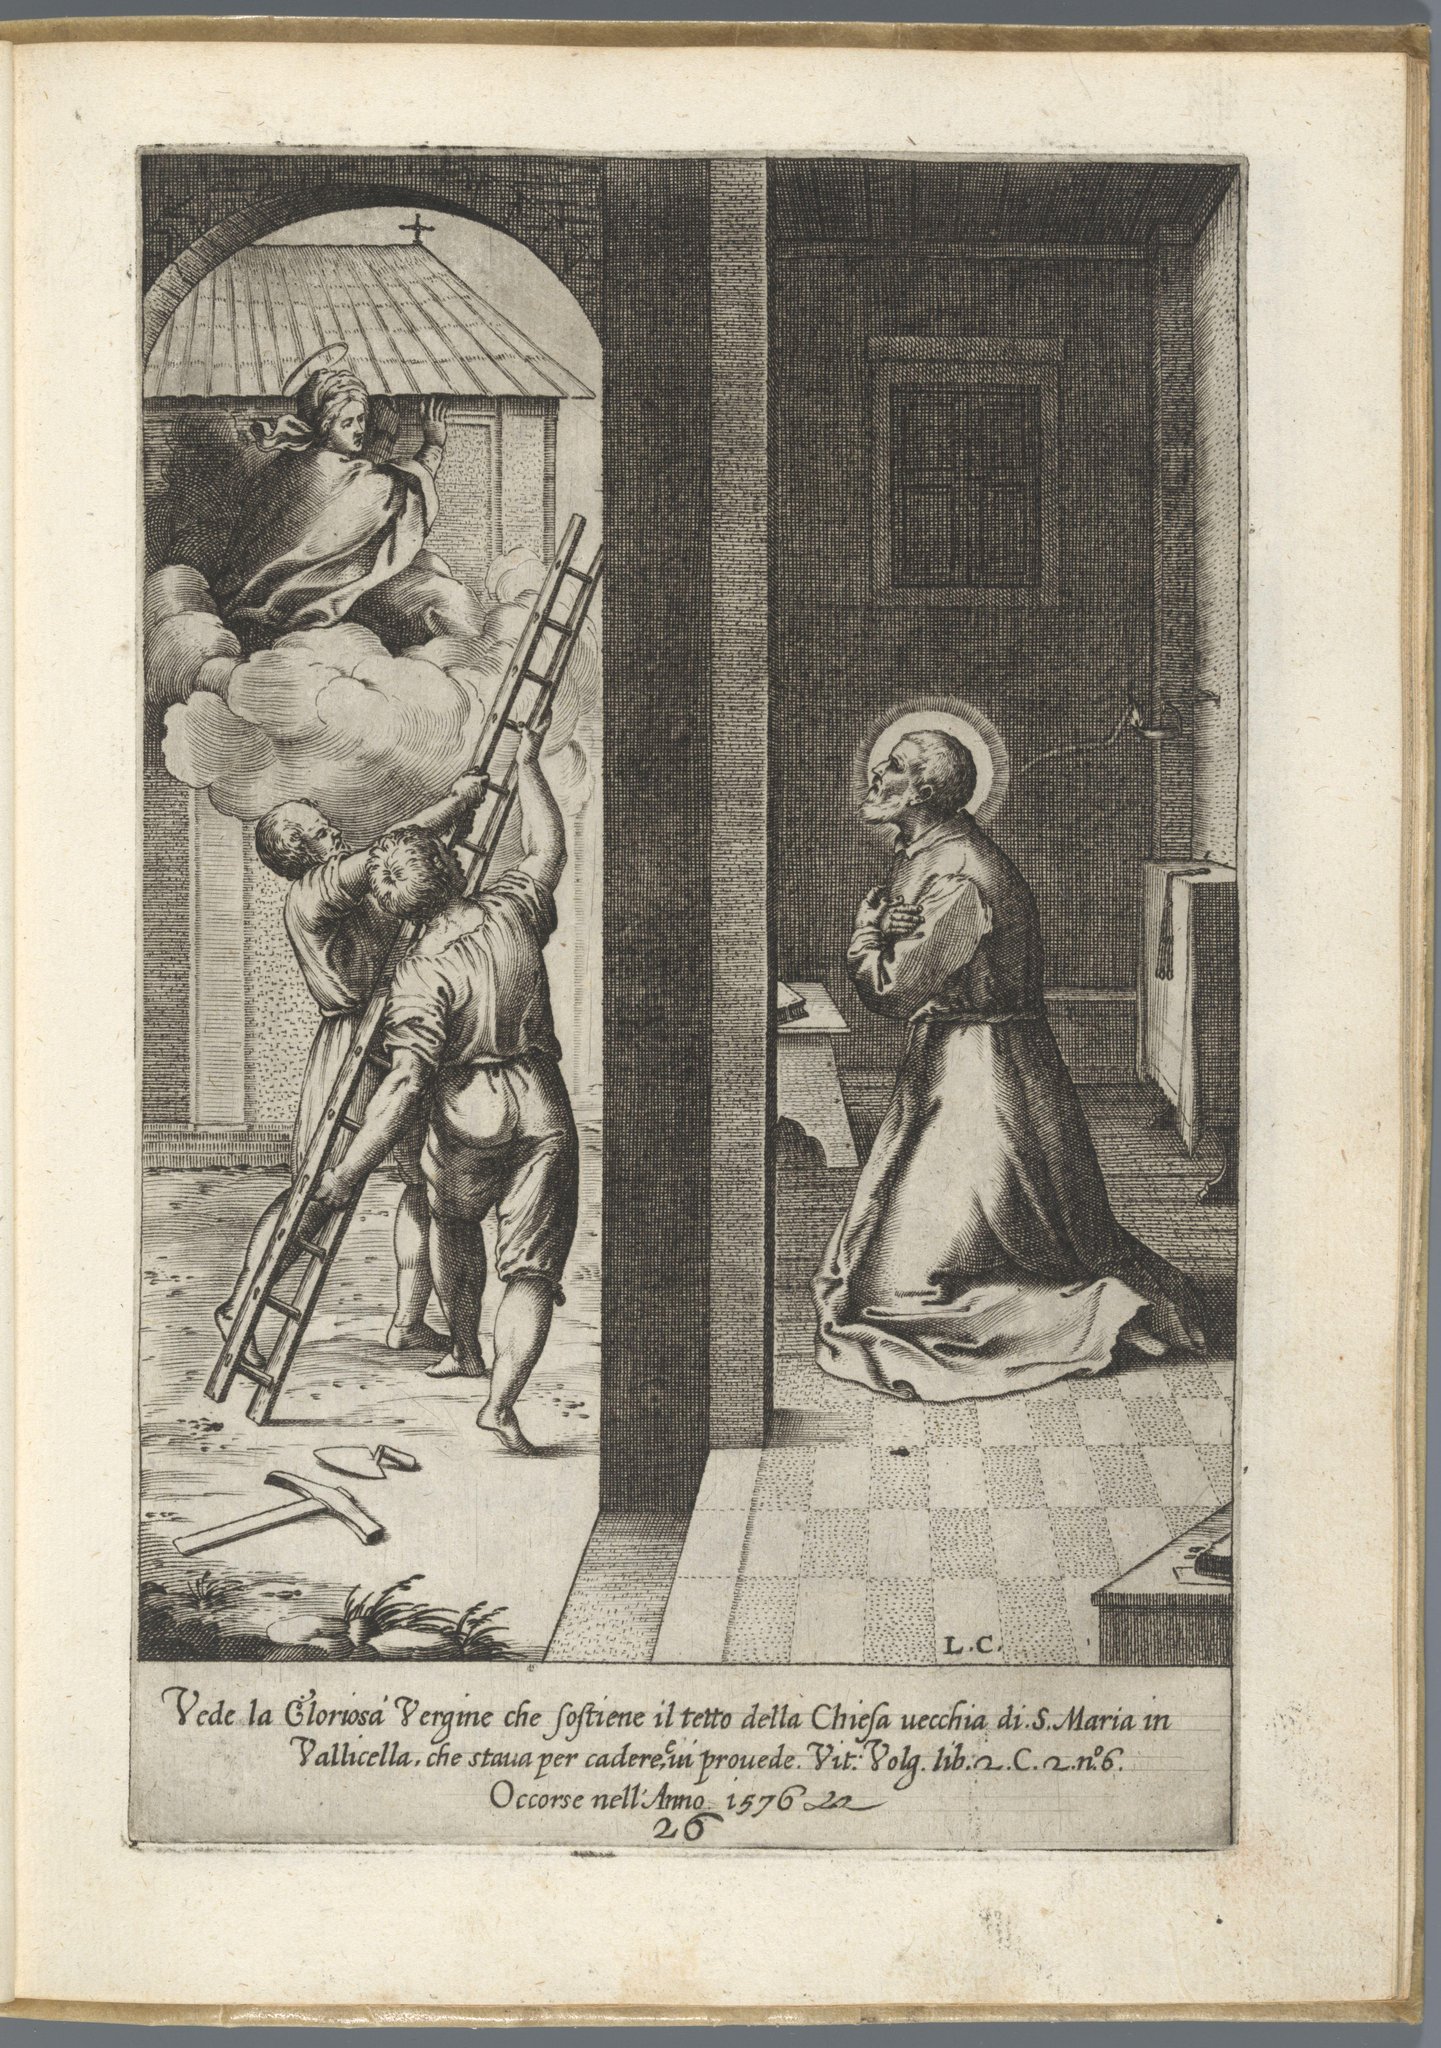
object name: print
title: Filippo Neri ziet Maria het dak van de Santa Maria in Vallicella dragen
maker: luca ciamberlano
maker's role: painter, print maker, publisher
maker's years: 1570-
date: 1630-1641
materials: paper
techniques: engraving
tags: rome, clergyman, the founder of the congregation of the oratory (oratorians) philip neri; possible attributes: lily, rosary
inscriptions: collector's mark: Lugt 2228, collector's mark: Lugt 2760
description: Filippo Neri ziet Maria voorkomt dat het dak van de oude kerk van de Santa Maria in Vallicella ineenstort (1576). Prent nr. 26 in een serie van 44 prenten met scènes uit het leven van de heilige Filippo Neri.